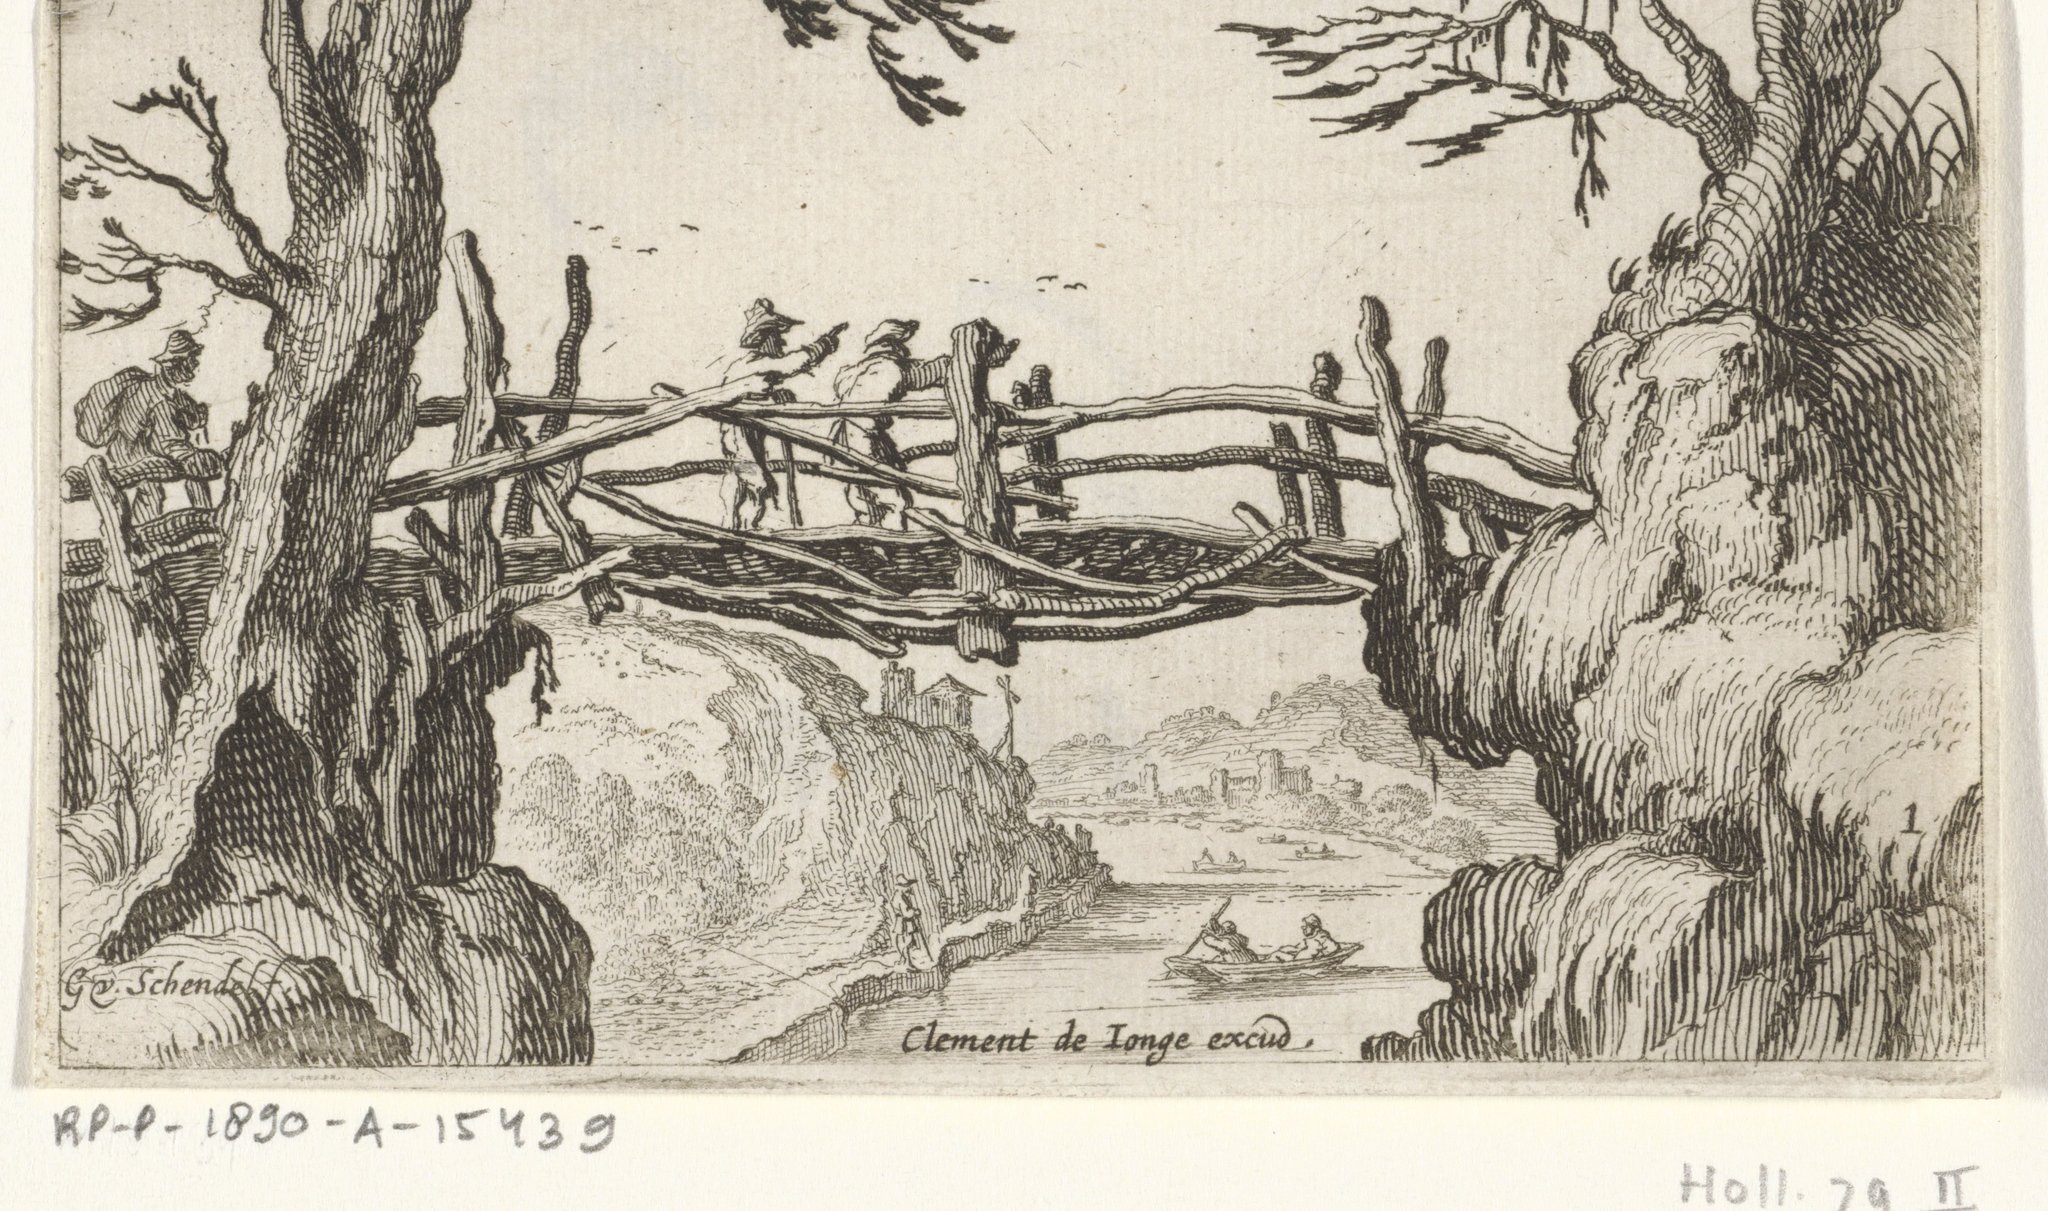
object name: print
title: Drie wandelaars op een houten brug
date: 1640-1670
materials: paper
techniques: etching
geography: amsterdam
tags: rowing-boat, canoe, etc., bridge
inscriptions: collector's mark: Lugt 2228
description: Drie wandelaars op een houten brug over een rivier. Boten op de rivier. De prent maakt deel uit van een serie van twaalf landschappen.